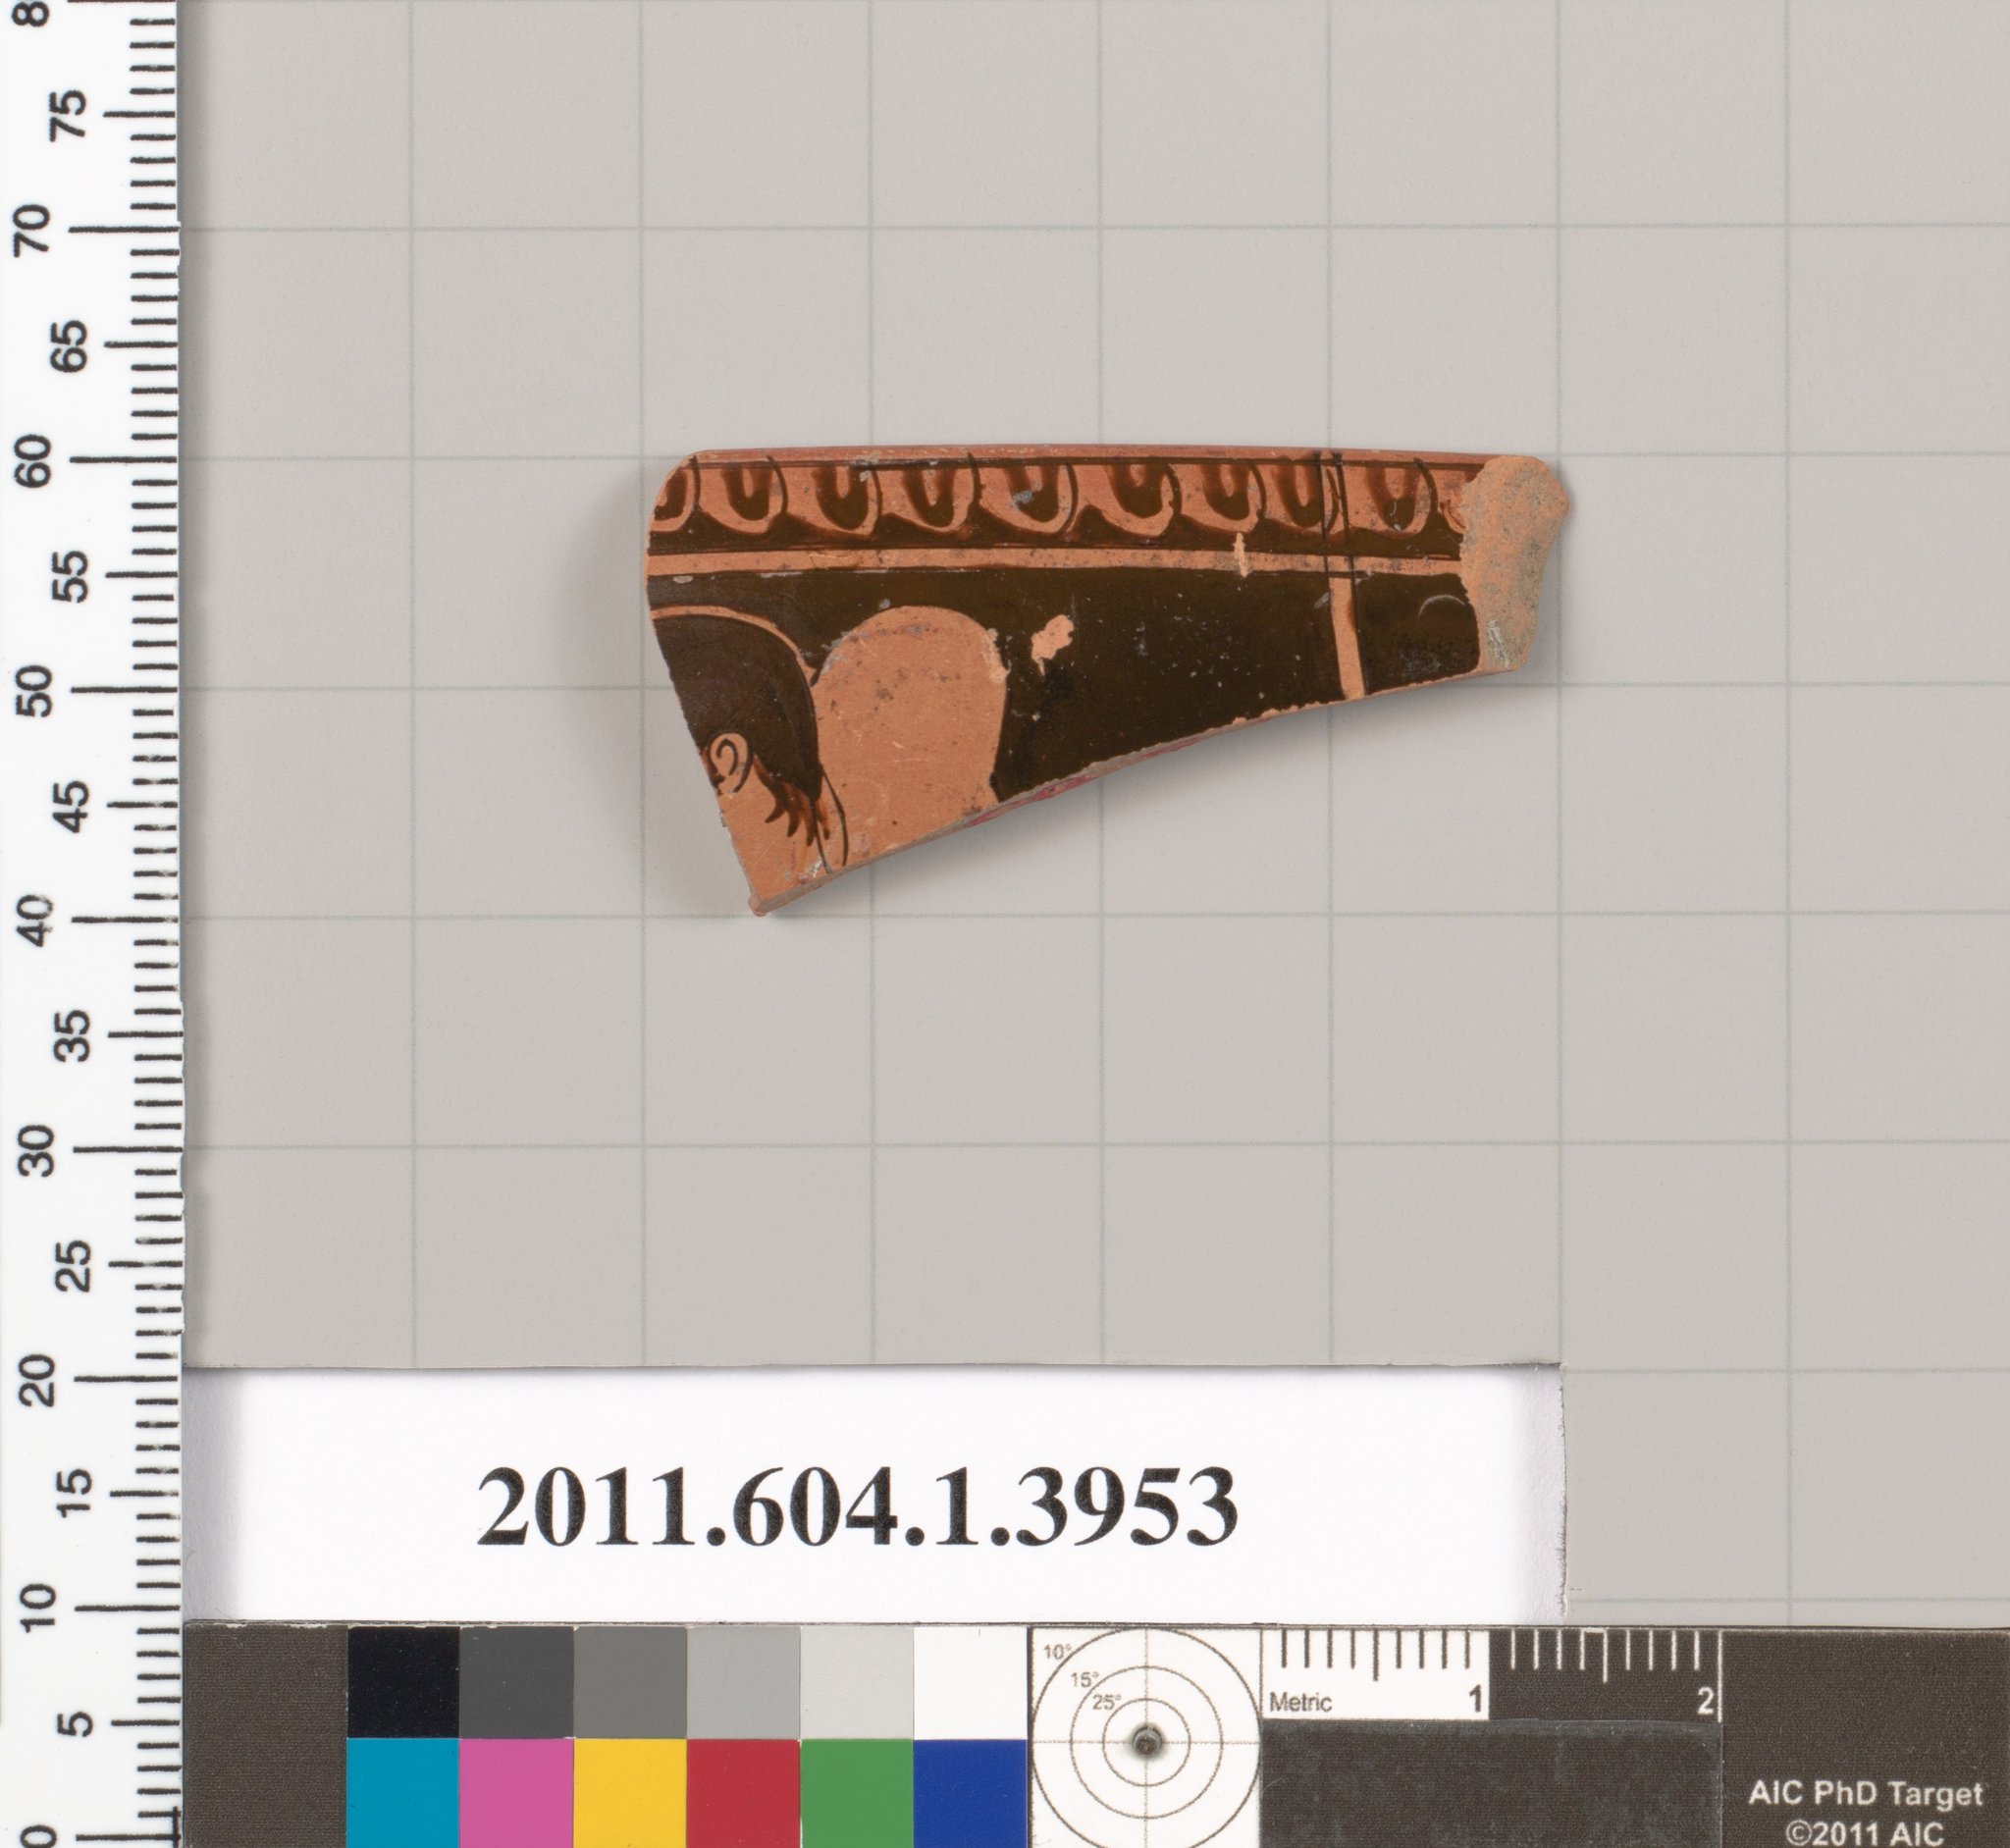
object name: kylix fragment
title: Terracotta rim fragment of a kylix (drinking cup)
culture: greek, attic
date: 475-451 BCE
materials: terracotta